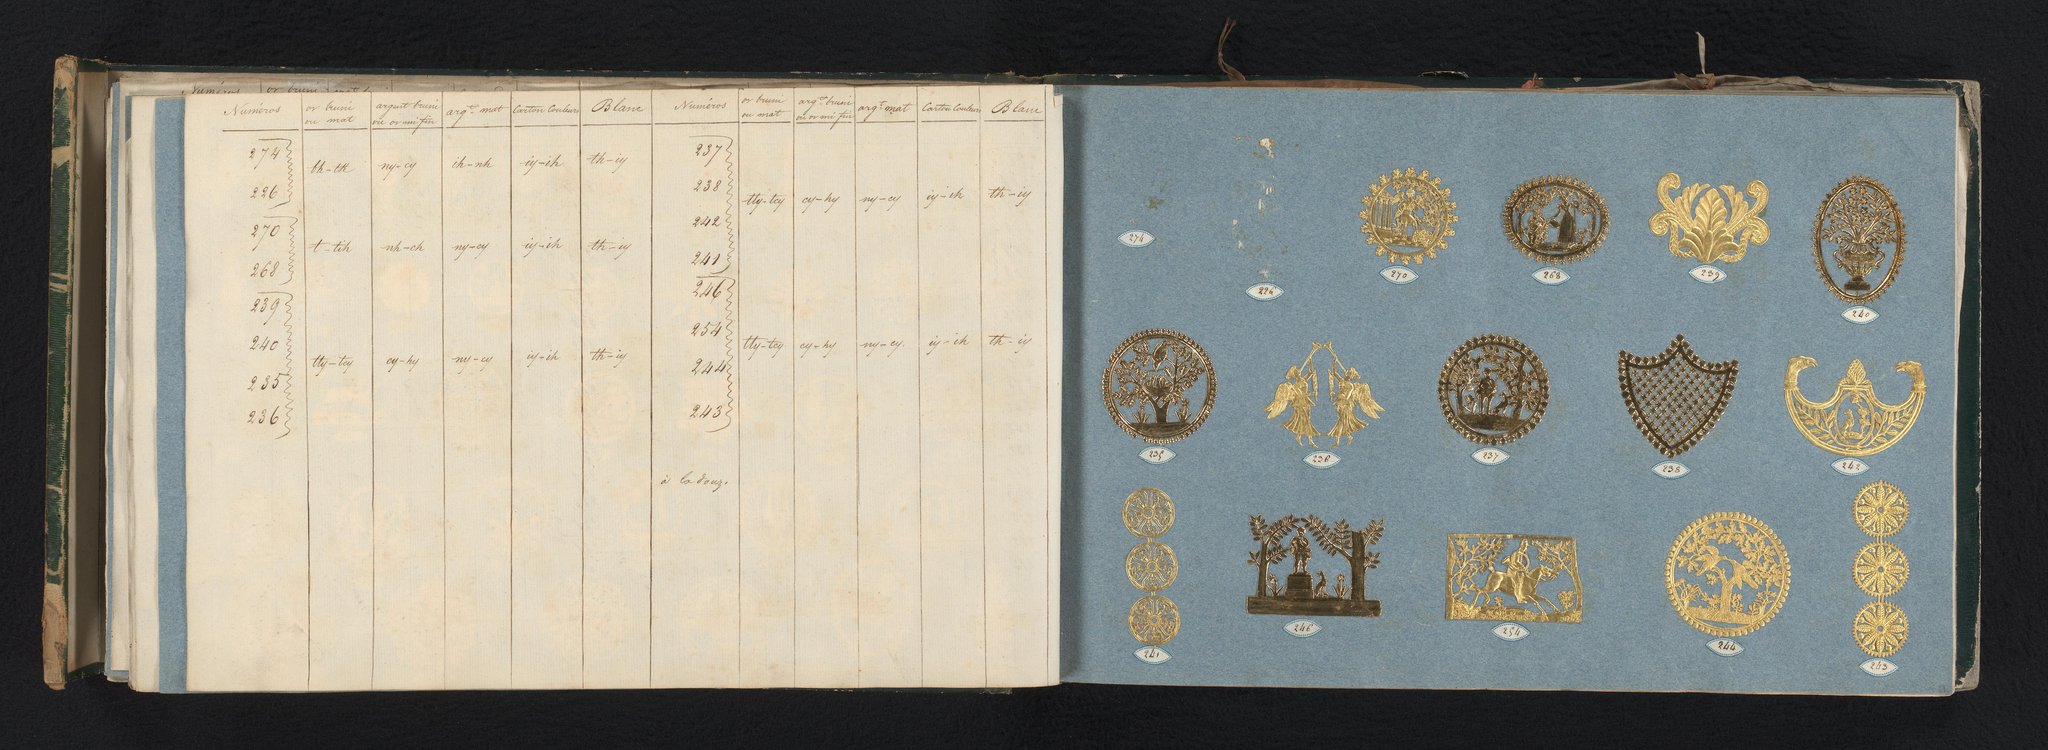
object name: album leaf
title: Twee bladzijden met stalen van vignetten van goudkleurig metaalpapier en bijbehorend tabel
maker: Anonymous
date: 1830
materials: gold leaf, ink, paper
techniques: manufacturing, writing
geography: france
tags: ornaments ~ art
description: Twee bladzijden met rechts 14 opgeplakte en met etiketten genummerde (274-243) stalen van afzonderlijke vignetten en emblemen van goudkleurig metaalpapier (stalen nrs. 274 en 226 ontbreken). Op de tegenoverliggende linkerbladzijde een tabel met de handgeschreven corresponderende specificaties (in code) per ornament. Onderdeel van het stalenboek geschonken door de dames Van Rijn, vermoedelijk van een Franse papierfabrikant van luxe papieren, of diens vertegenwoordiger in Nederland, ca. 1830.